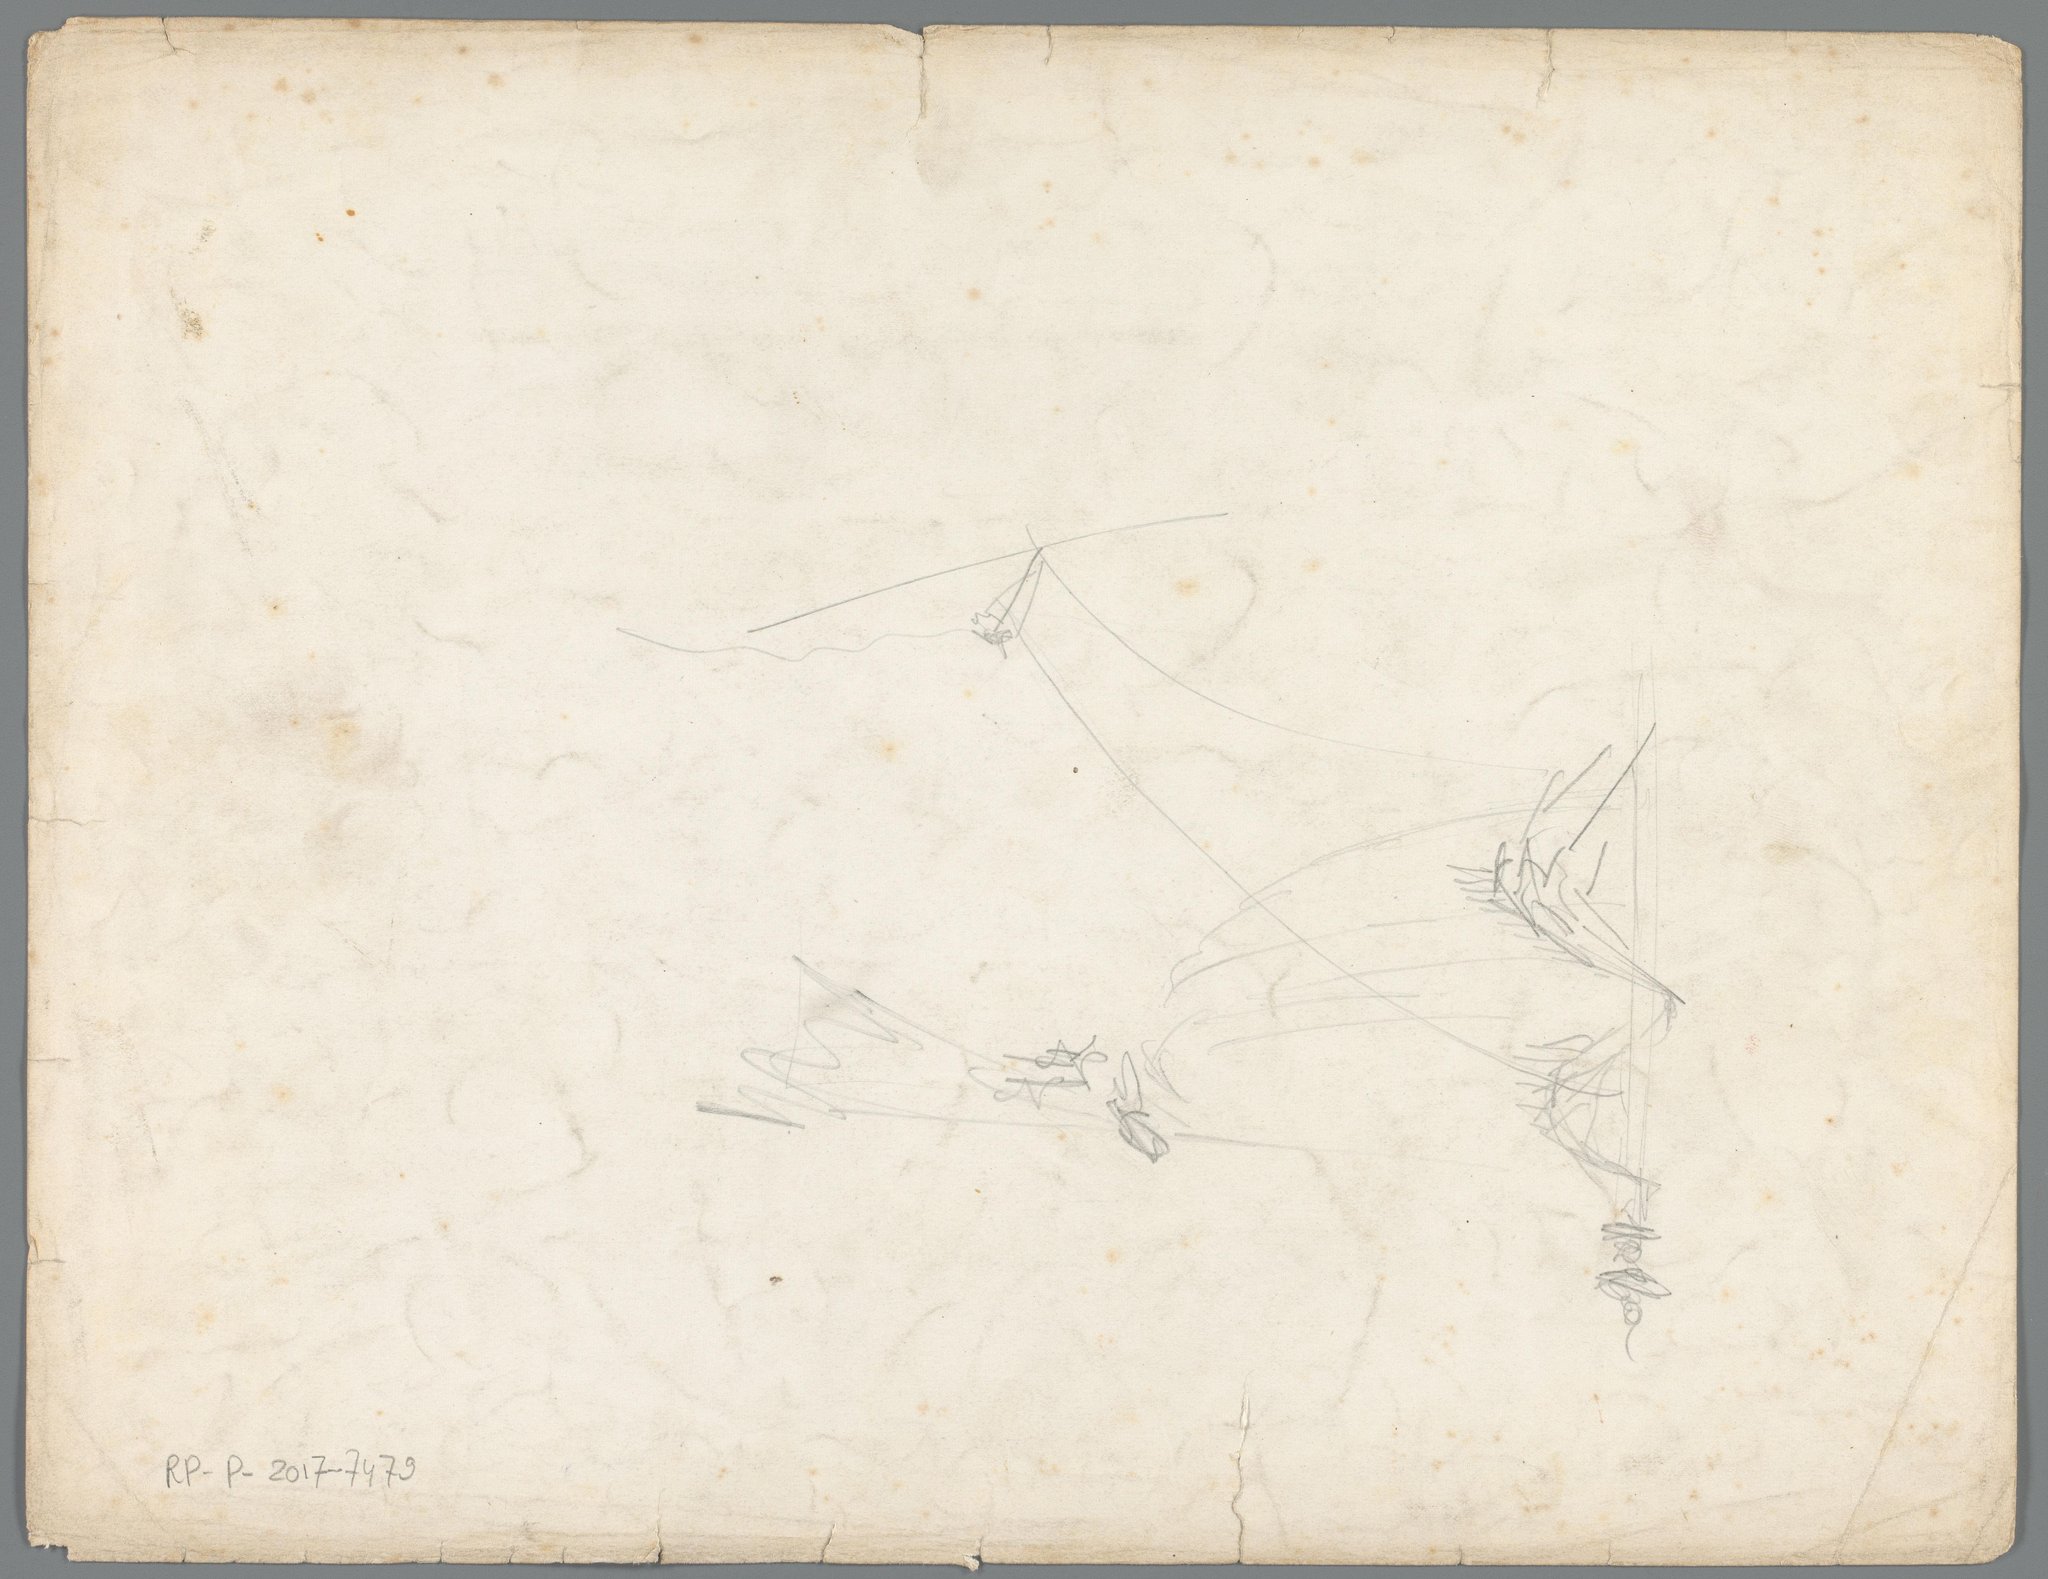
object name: drawing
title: Gordijnen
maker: Anonymous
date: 1860-1899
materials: paper, pencil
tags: hangings and drapery